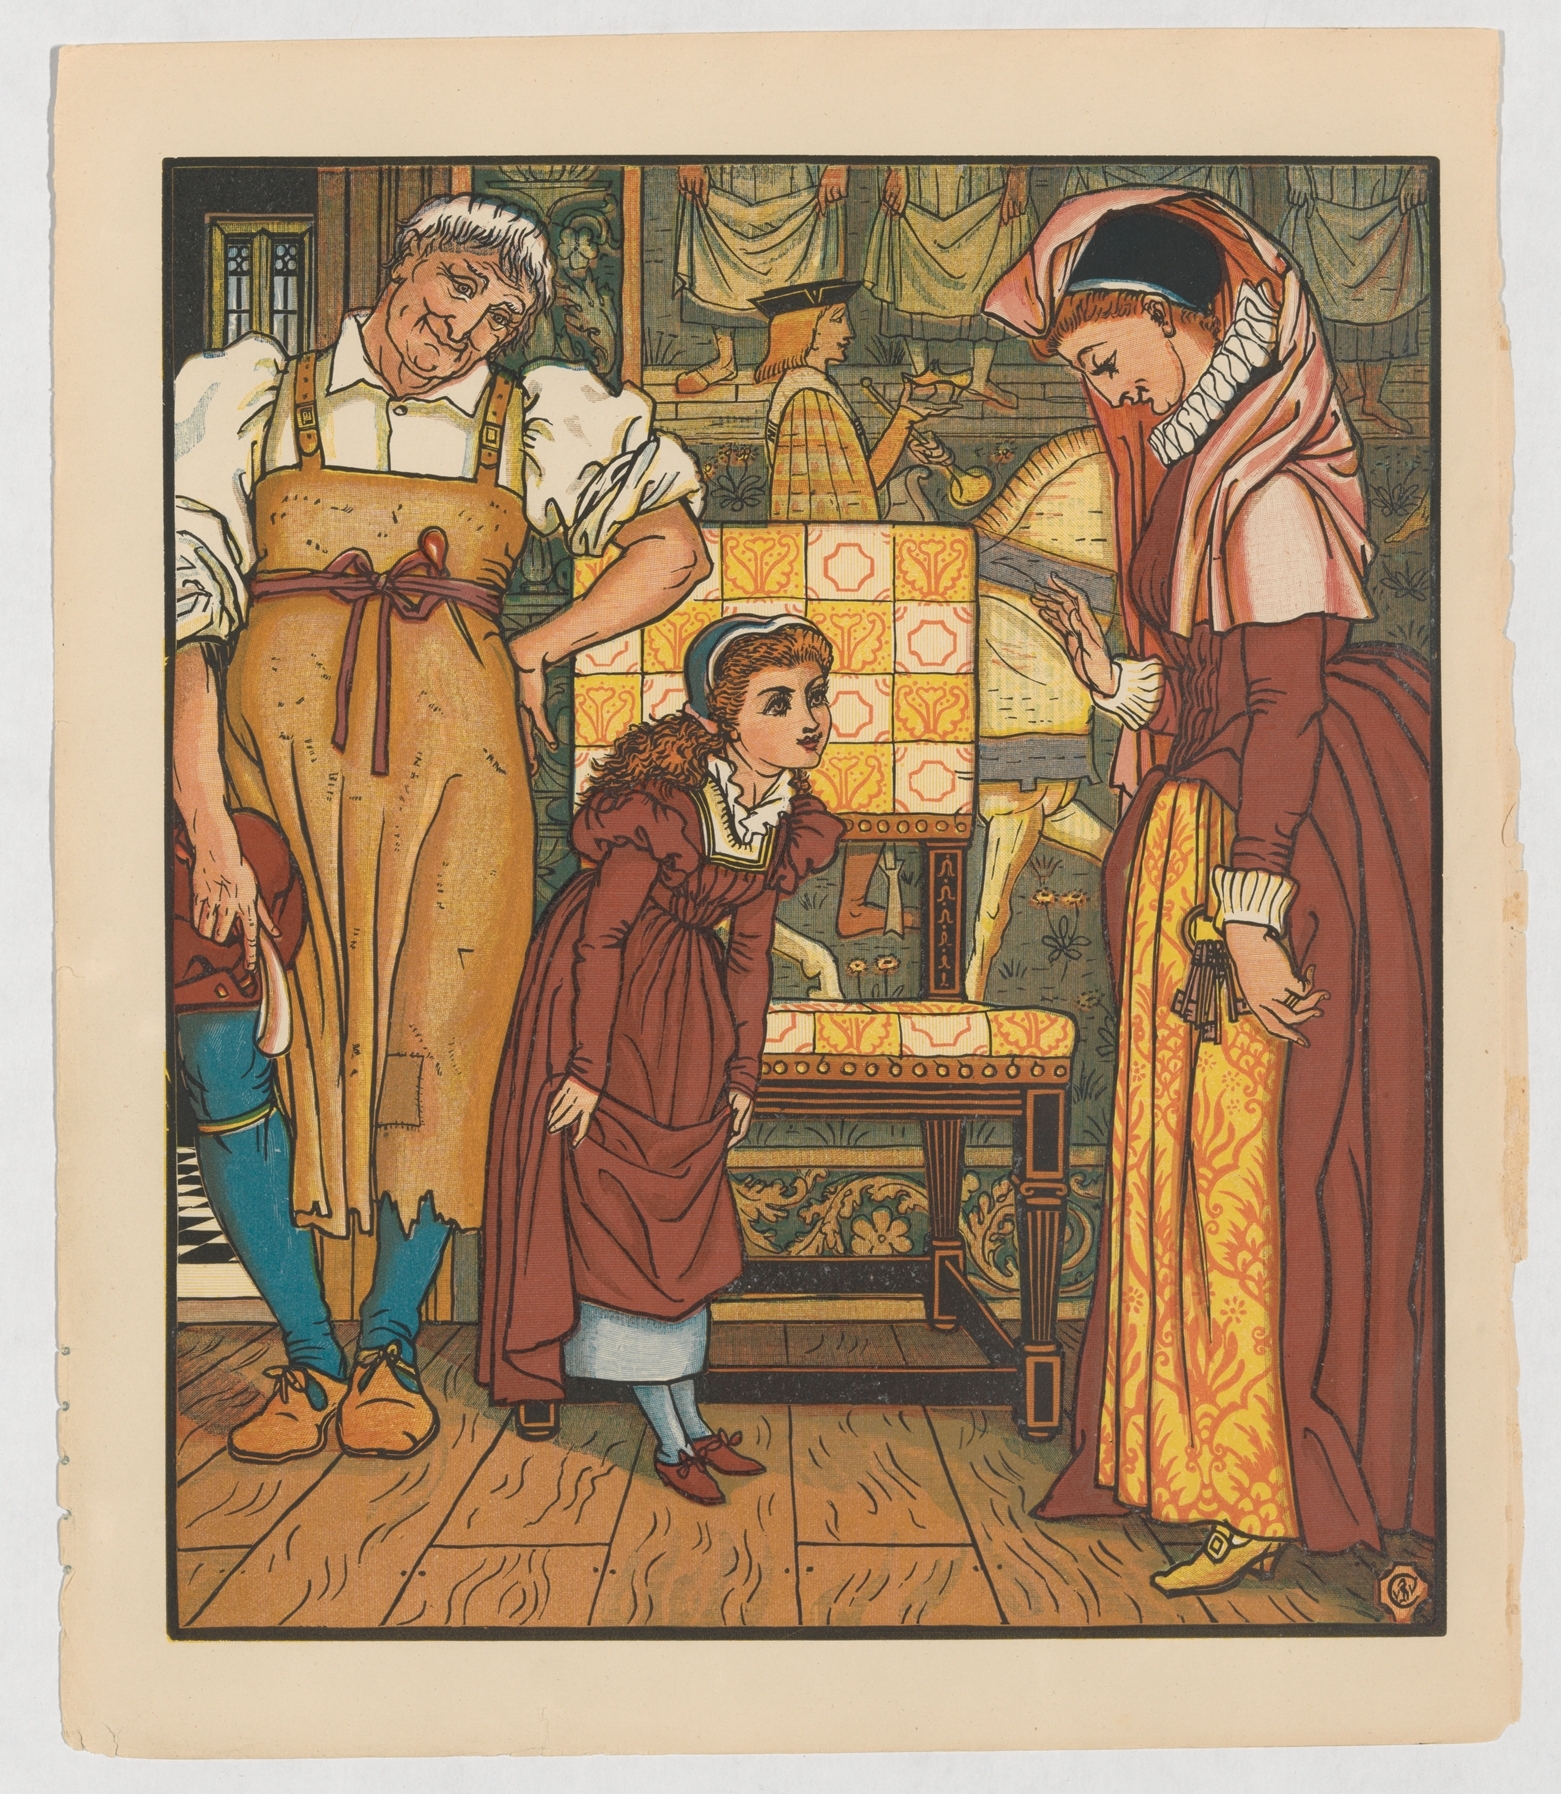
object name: book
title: Goody Two Shoes' Picture Book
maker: walter crane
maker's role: illustrator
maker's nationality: british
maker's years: 1845-1915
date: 1874-1876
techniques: printing, engraving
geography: new york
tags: girls,women,chairs